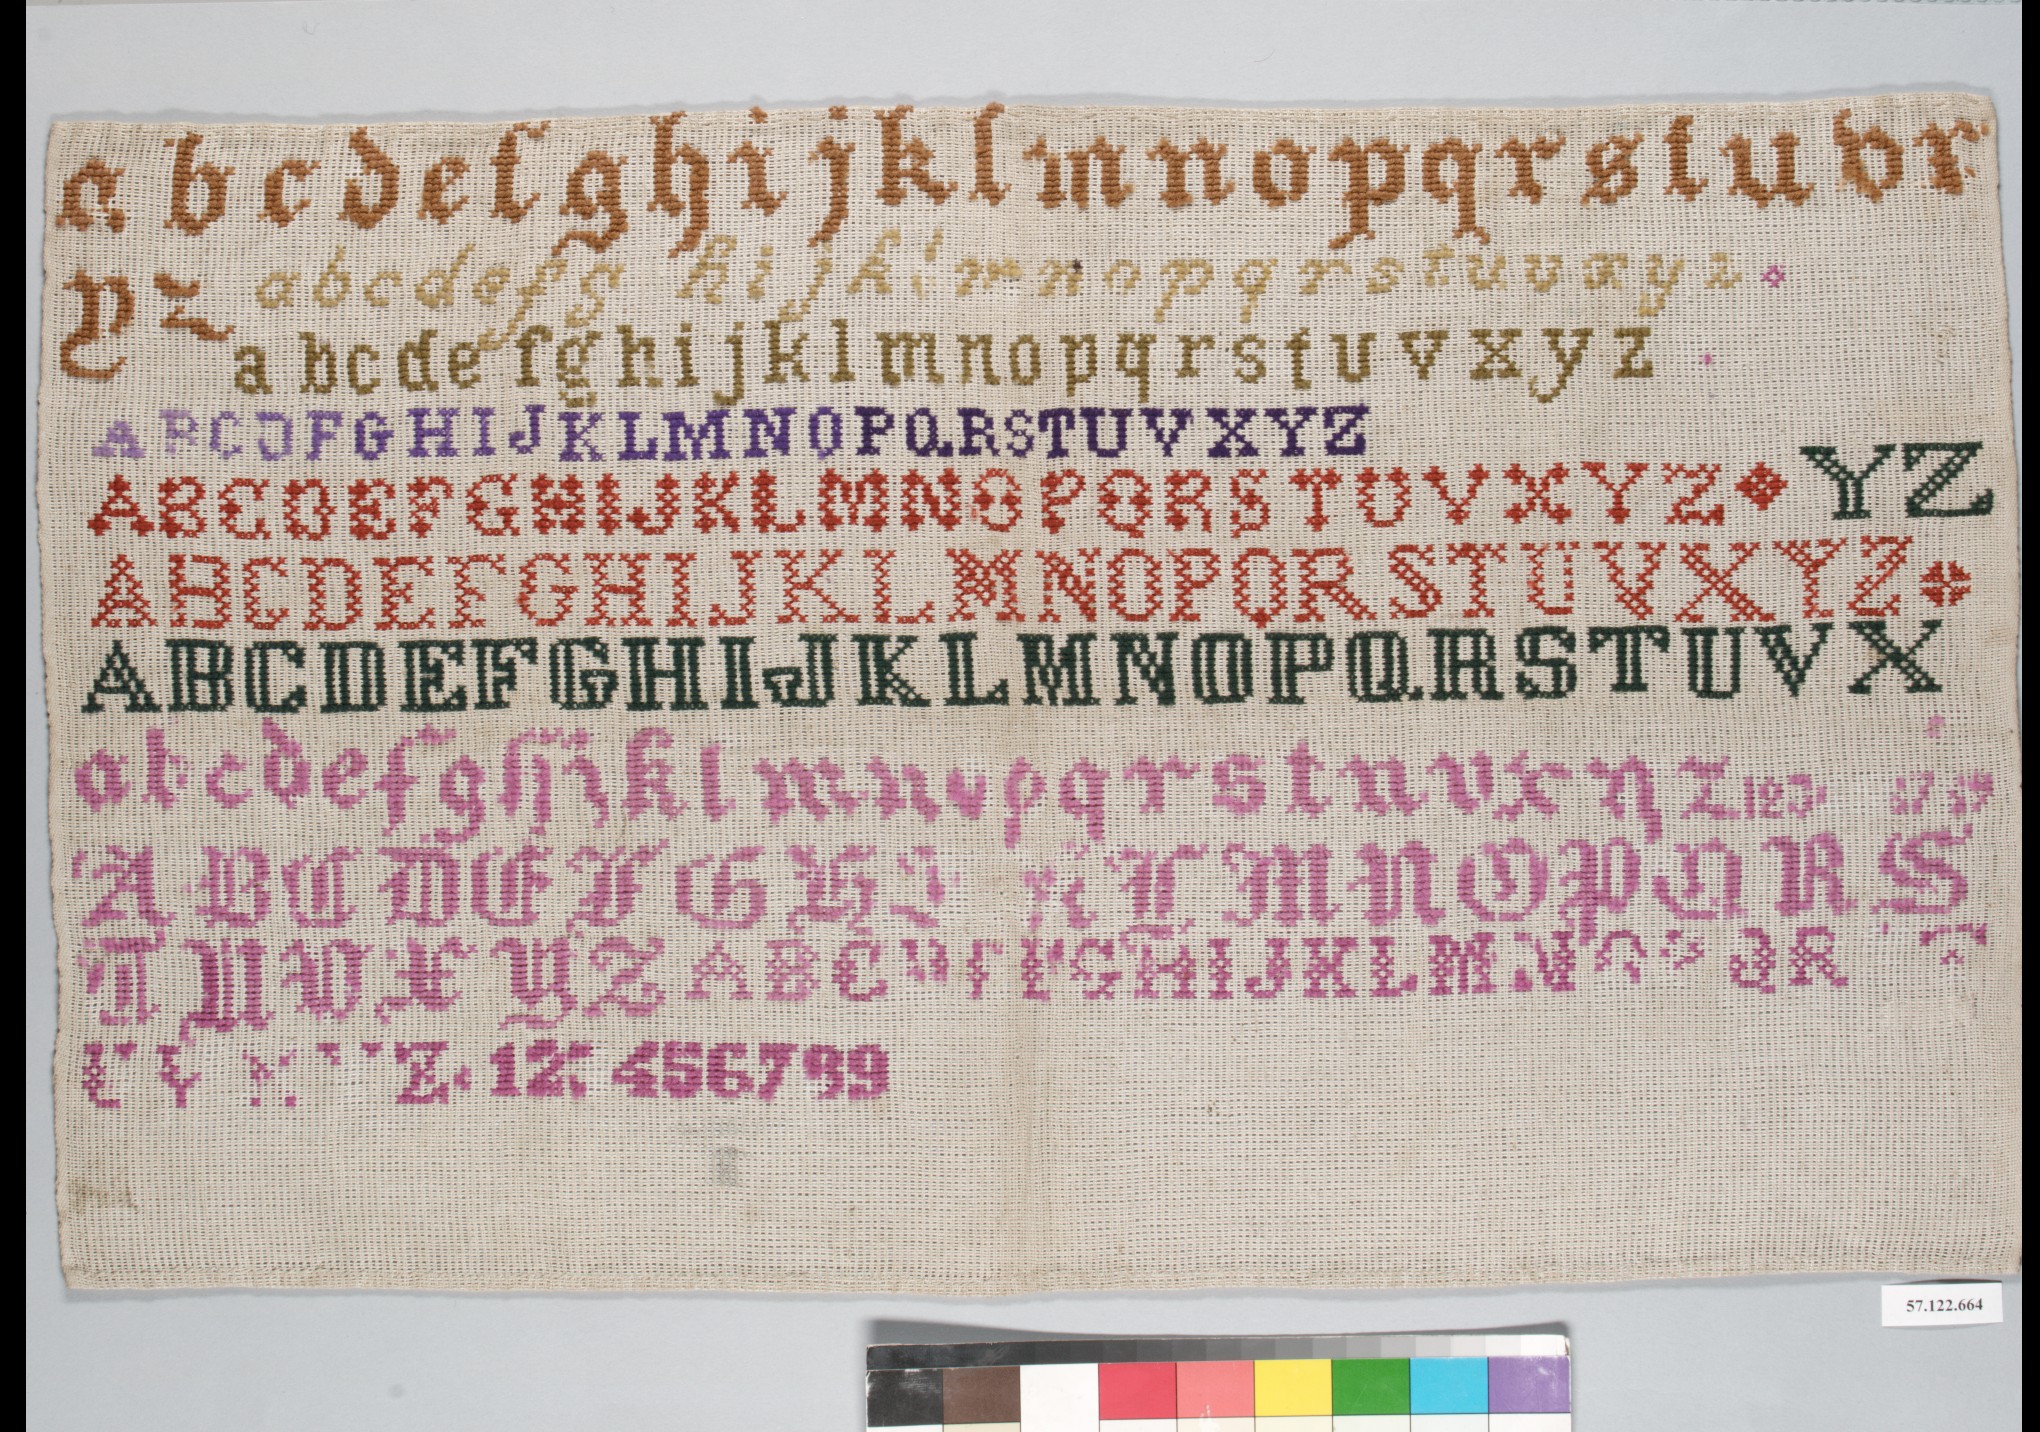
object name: sampler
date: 1801-1900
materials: canvas, wool